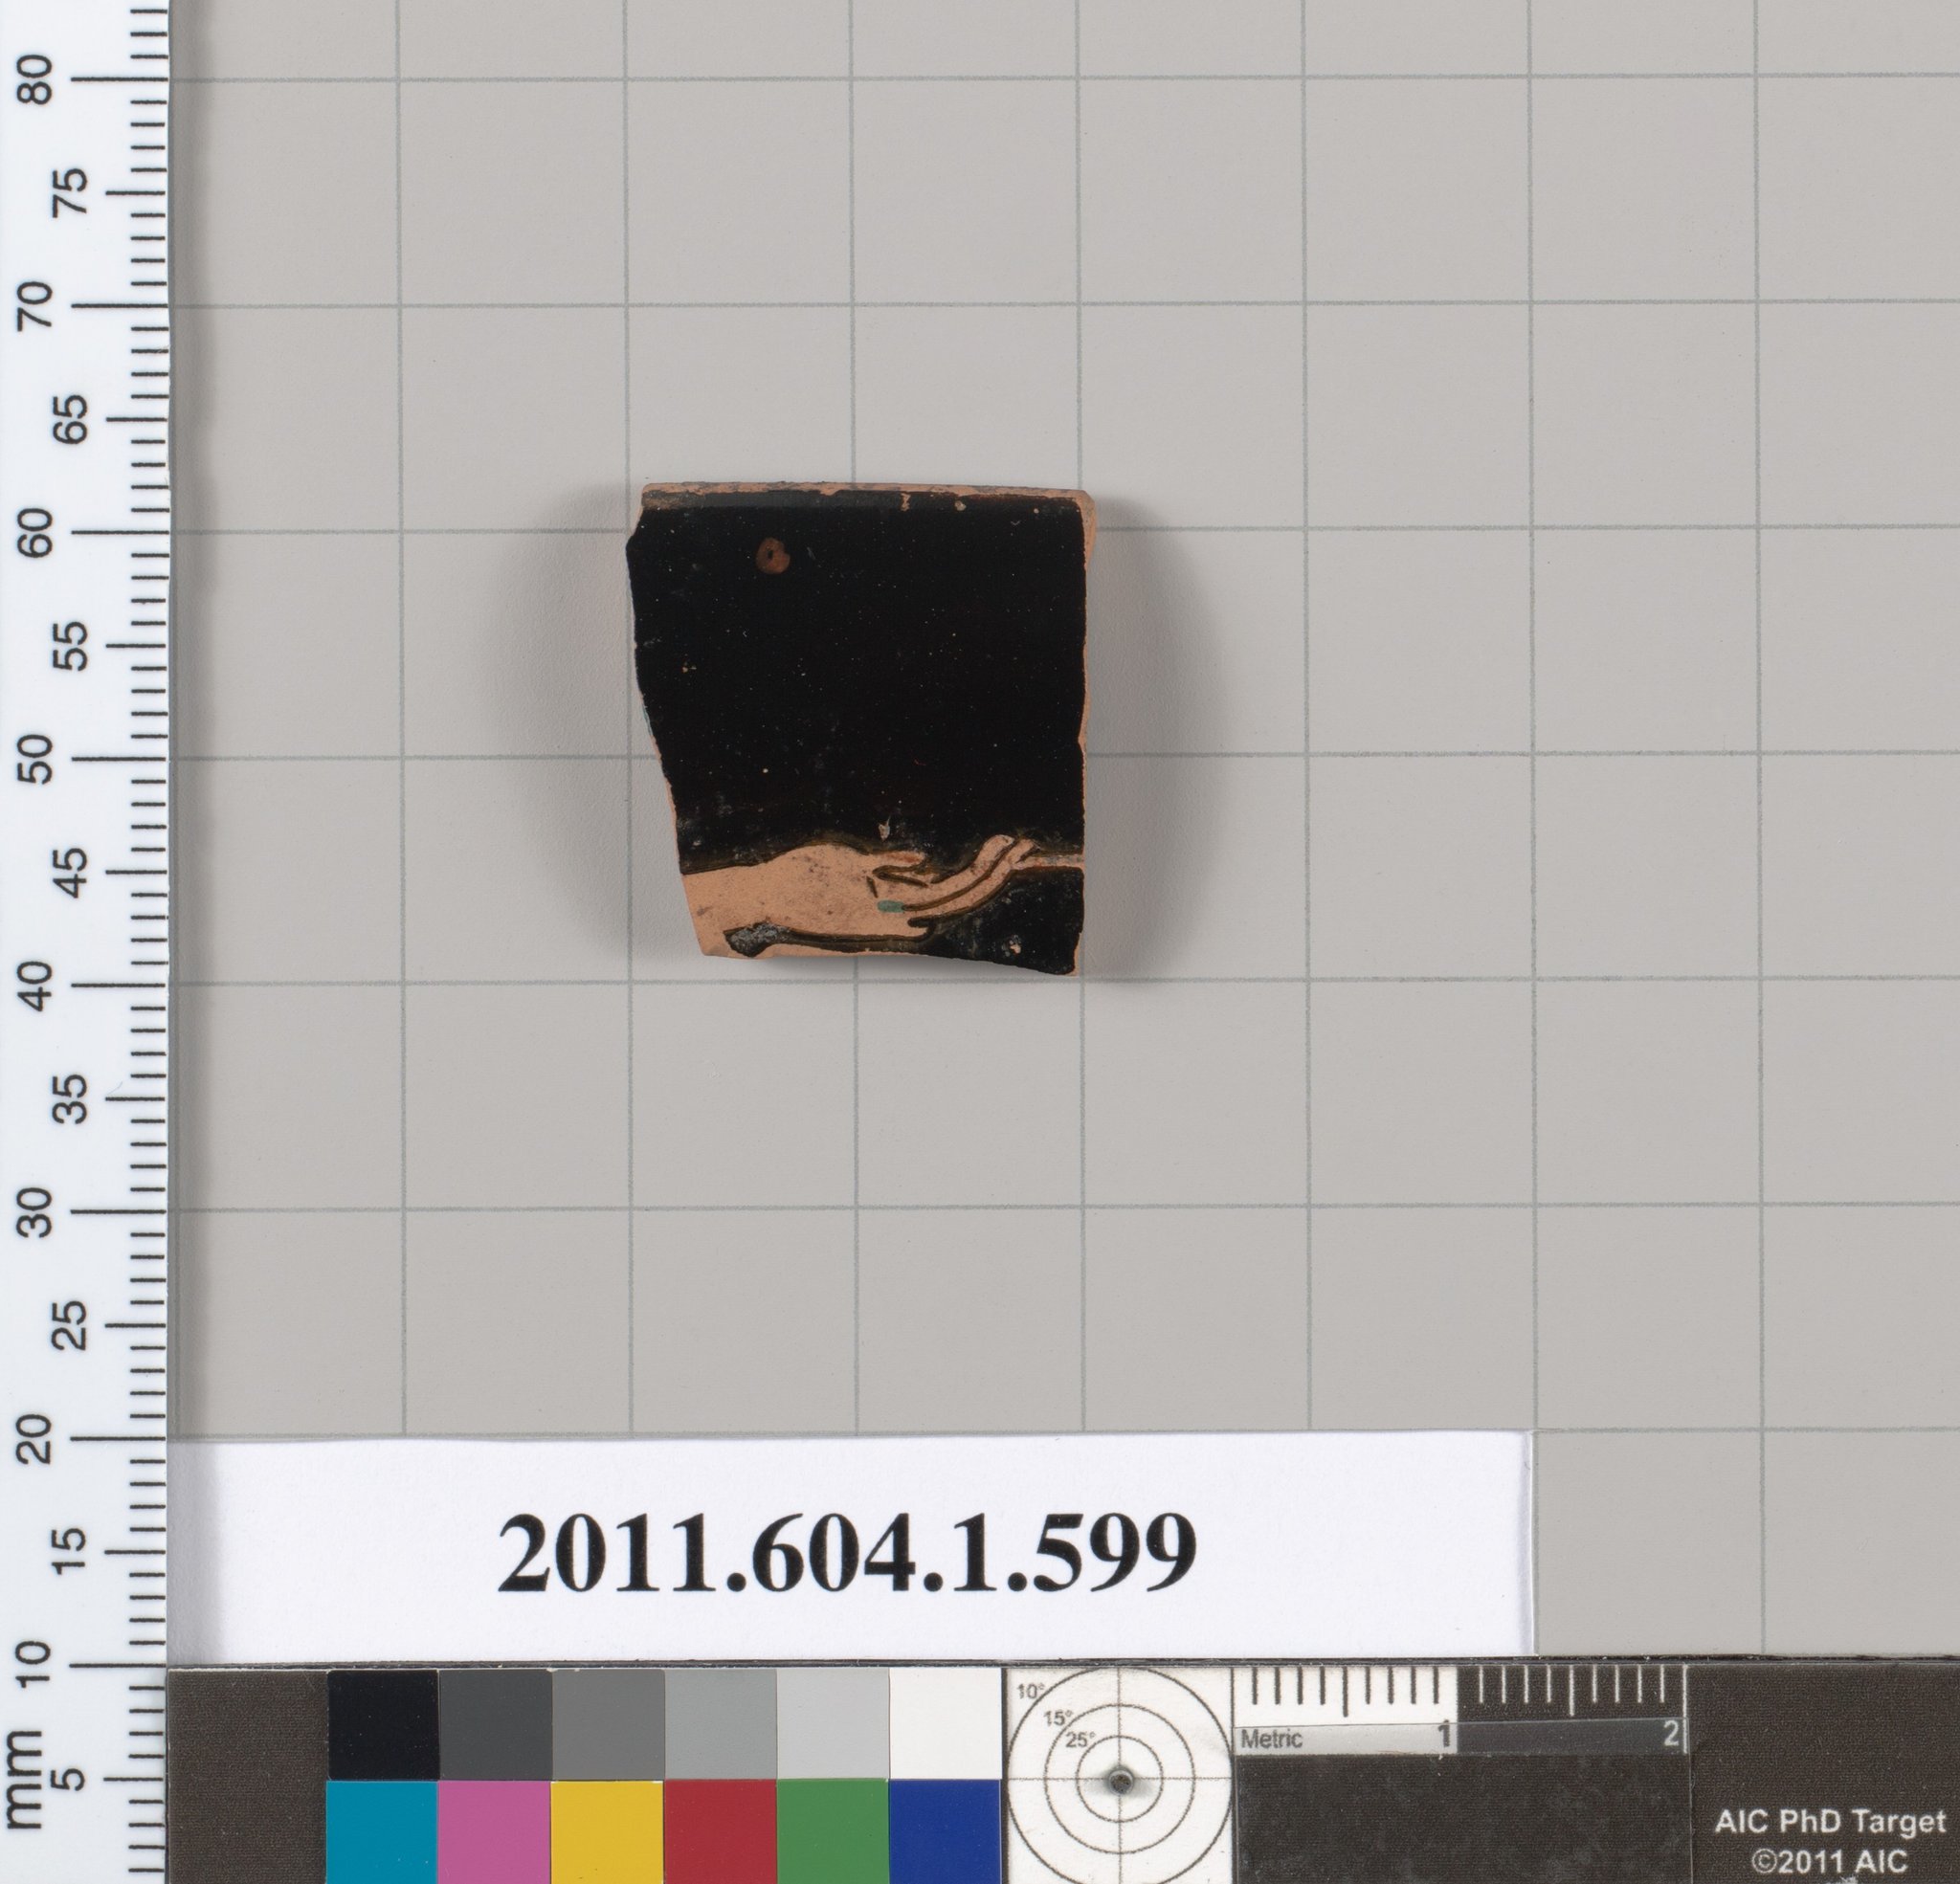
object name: kylix fragment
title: Terracotta rim fragment of a kylix (drinking cup)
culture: greek, attic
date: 475-451 BCE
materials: terracotta